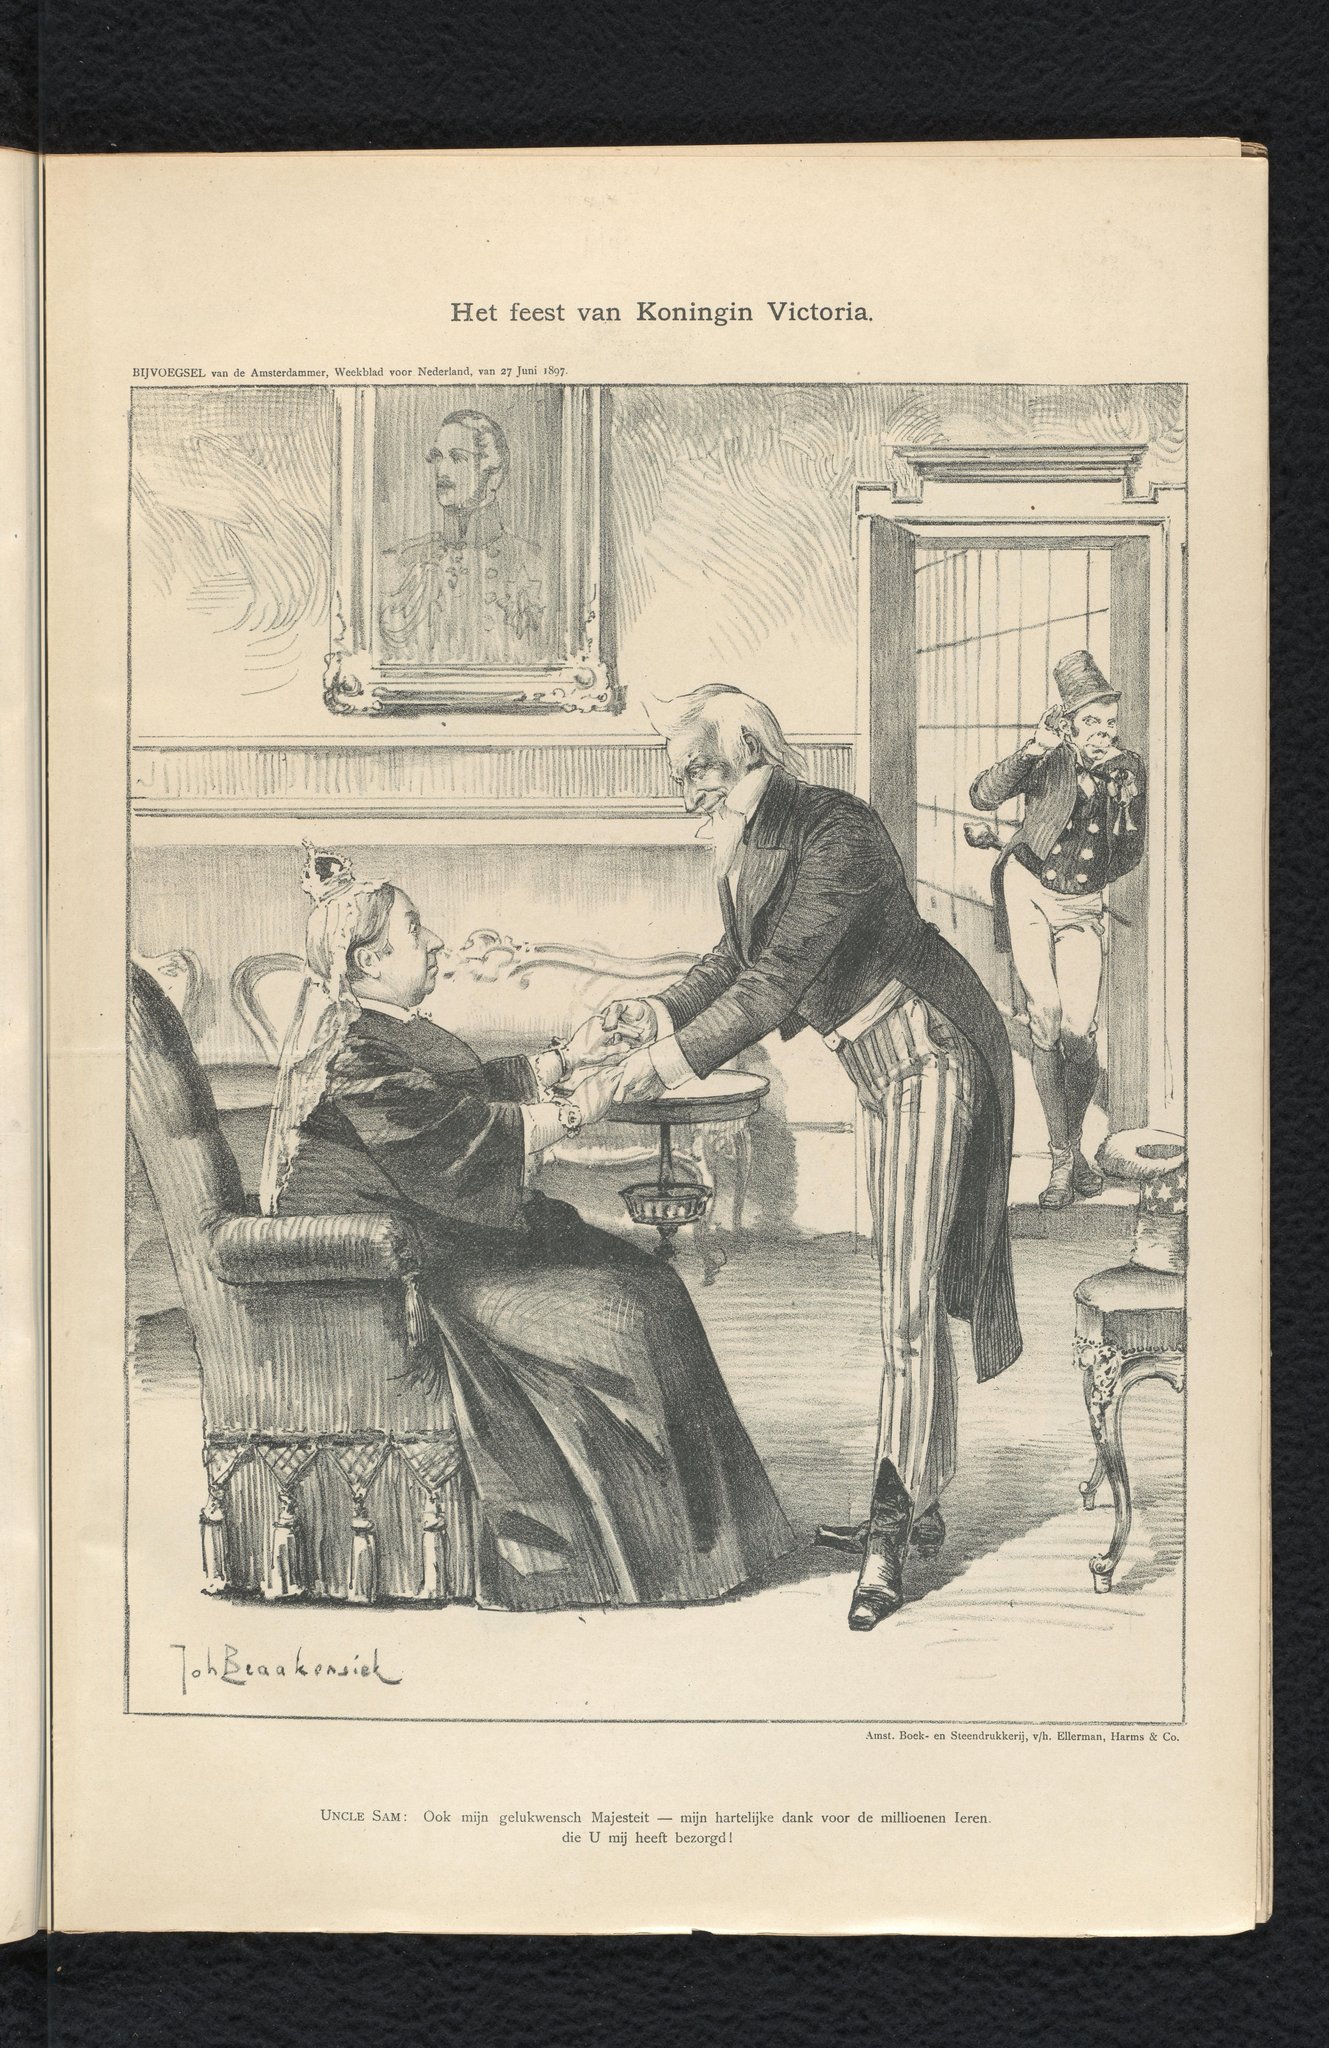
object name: cartoon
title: Het feest van Koningin Victoria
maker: johan braakensiek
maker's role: draughtsman, print maker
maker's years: 1858-1940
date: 1897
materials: paper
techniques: lithograph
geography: netherlands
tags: victoria (koningin van het verenigd koninkrijk en keizerin van india), europeans (with name), personifications of countries, nations, states, districts, etc., (descendants of) european emigrants to america, political caricatures and satires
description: Uncle Sam (de Verenigde Staten) dankt koningin Victoria voor de miljoenen Ieren die naar de VS zijn geëmigreerd. John Bull luistert in de deuropening.